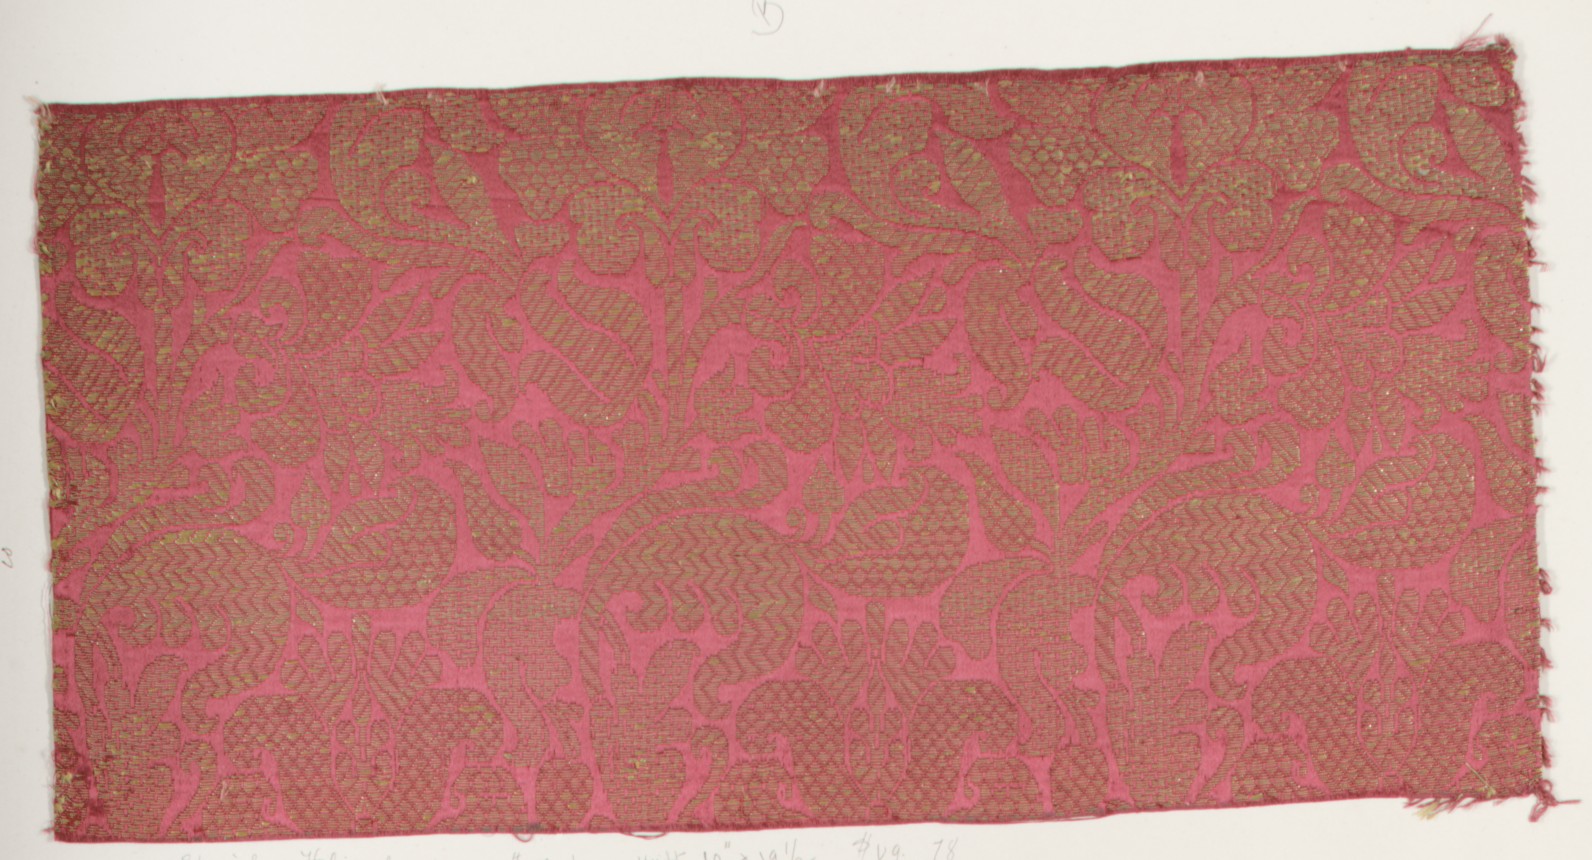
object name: fragment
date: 1601-1700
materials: metal thread, silk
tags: flowers,leaves